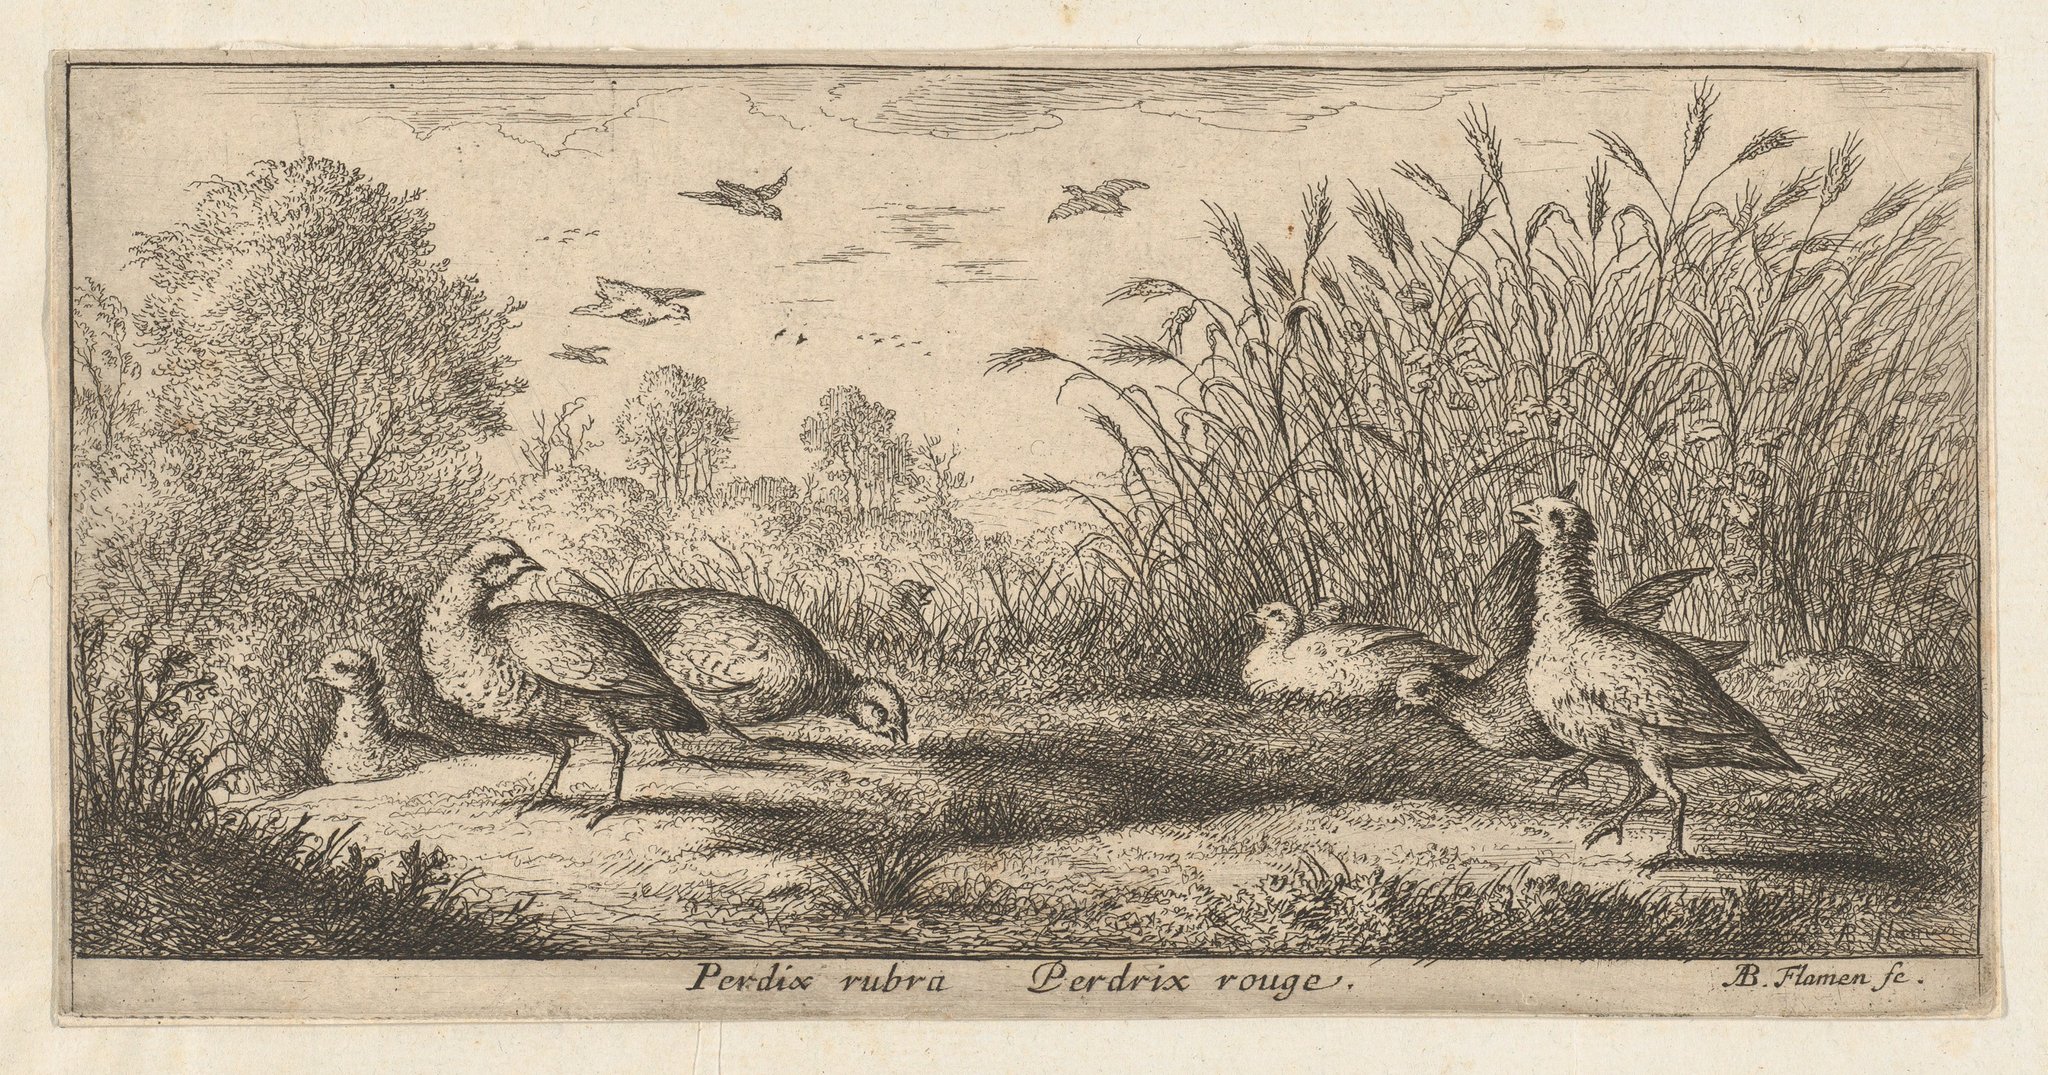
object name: print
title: Perdix rubra, Perdix rouge (The Red-Legged Partridge), from "Livre d'Oyseaux" (Book of Birds)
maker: albert flamen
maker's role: artist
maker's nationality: flemish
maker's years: 1615-1688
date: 1655-1660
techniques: etching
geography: france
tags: birds